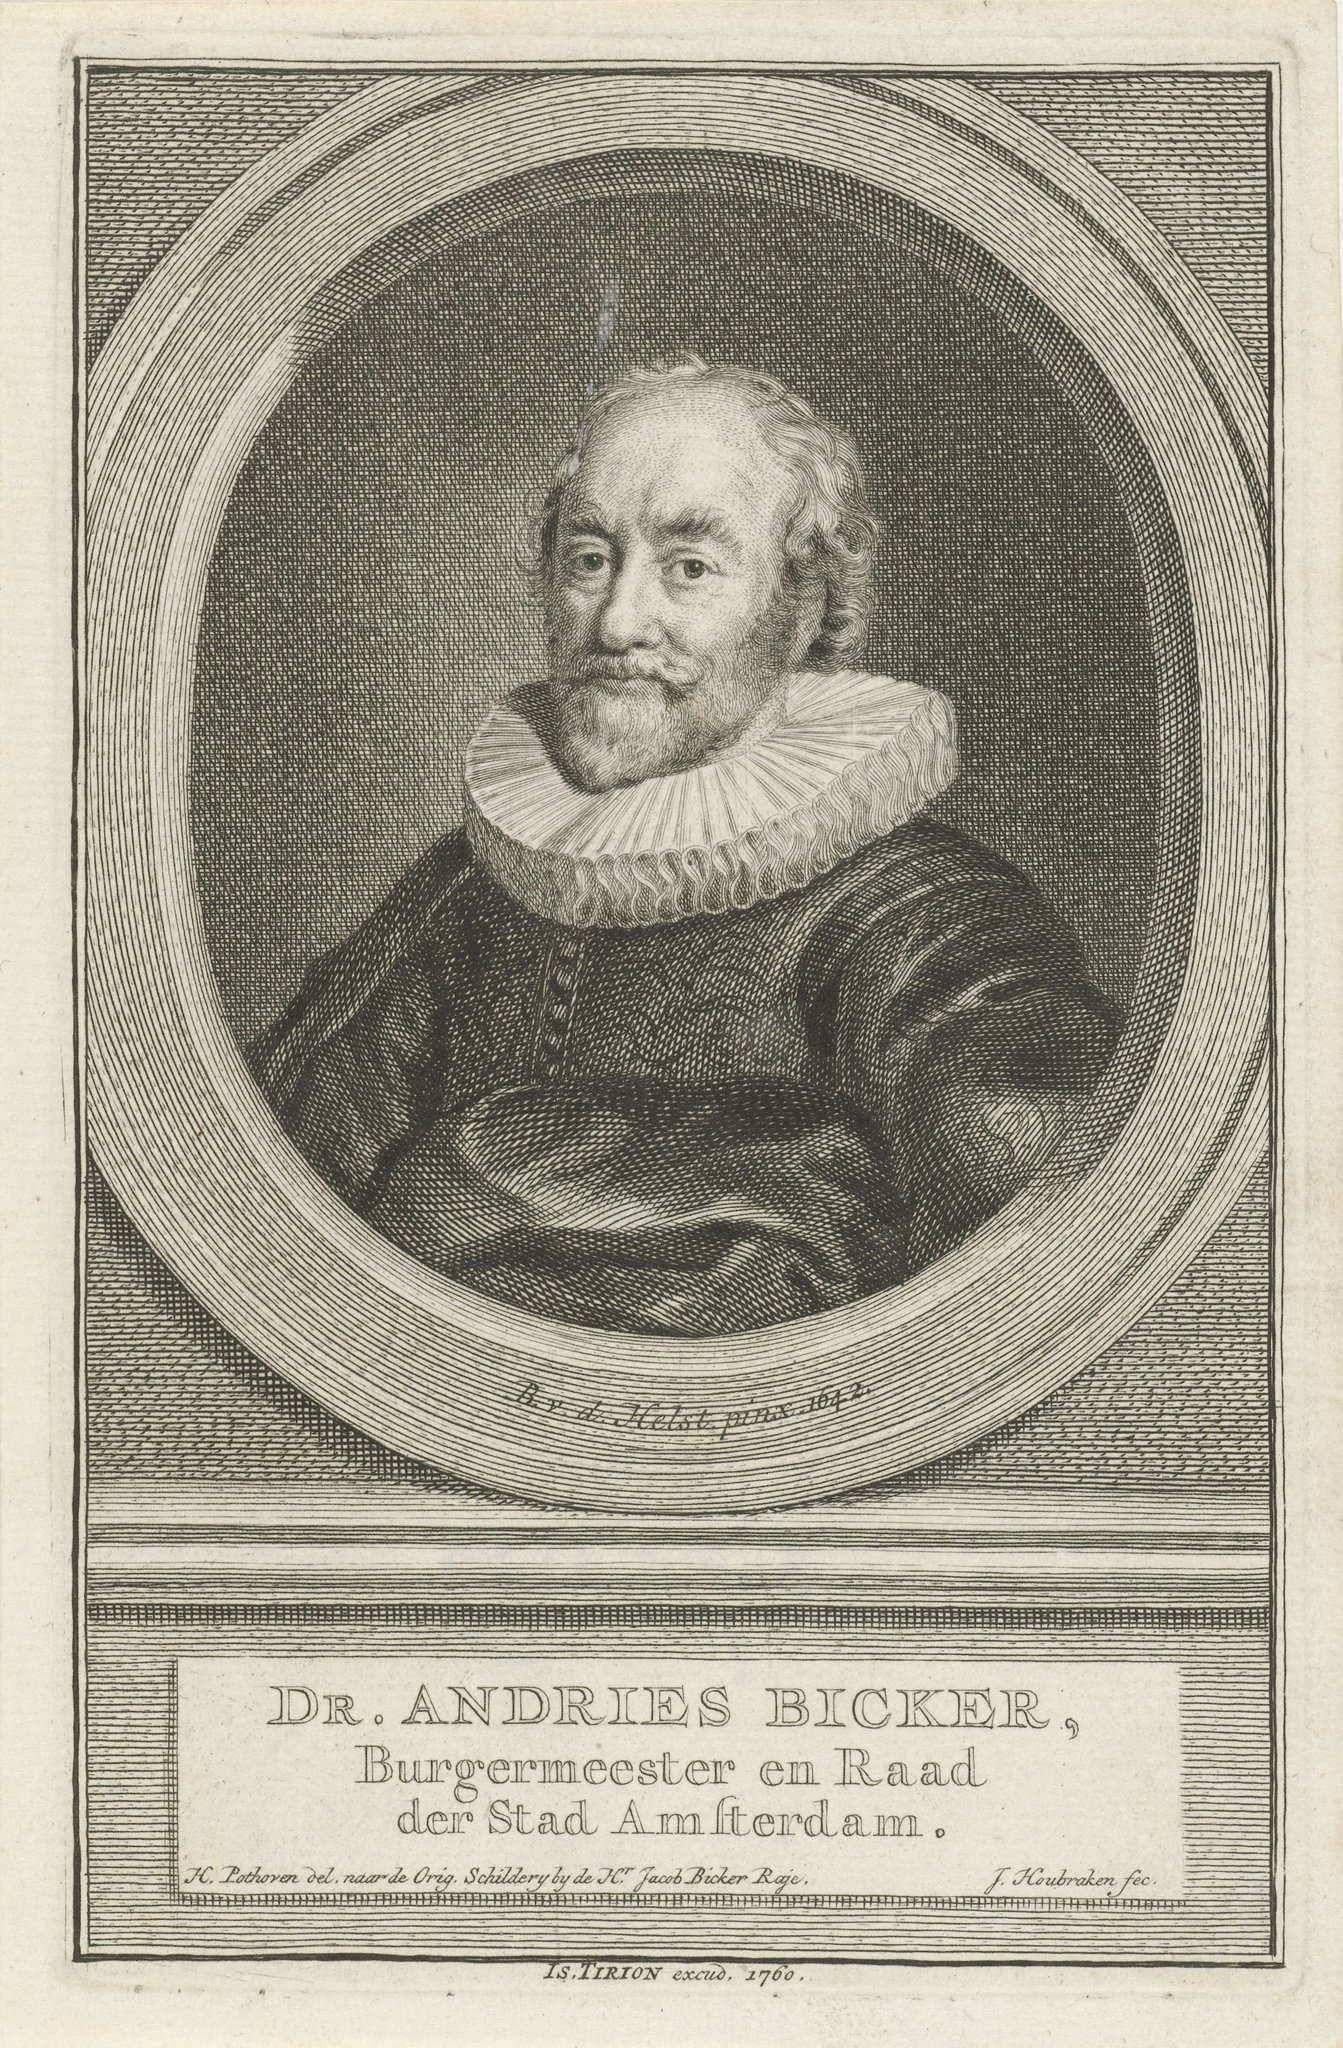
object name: print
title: Portret van Andries Bicker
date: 1760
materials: paper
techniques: engraving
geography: amsterdam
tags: mayor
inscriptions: collector's mark: Lugt 2228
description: Prent ook gebruikt in: Portraiten van vermaarde persoonadien, dienende tot een aanhangsel op de Vaderlandsche historie. Amsterdam, Isaak Tirion, 1761.